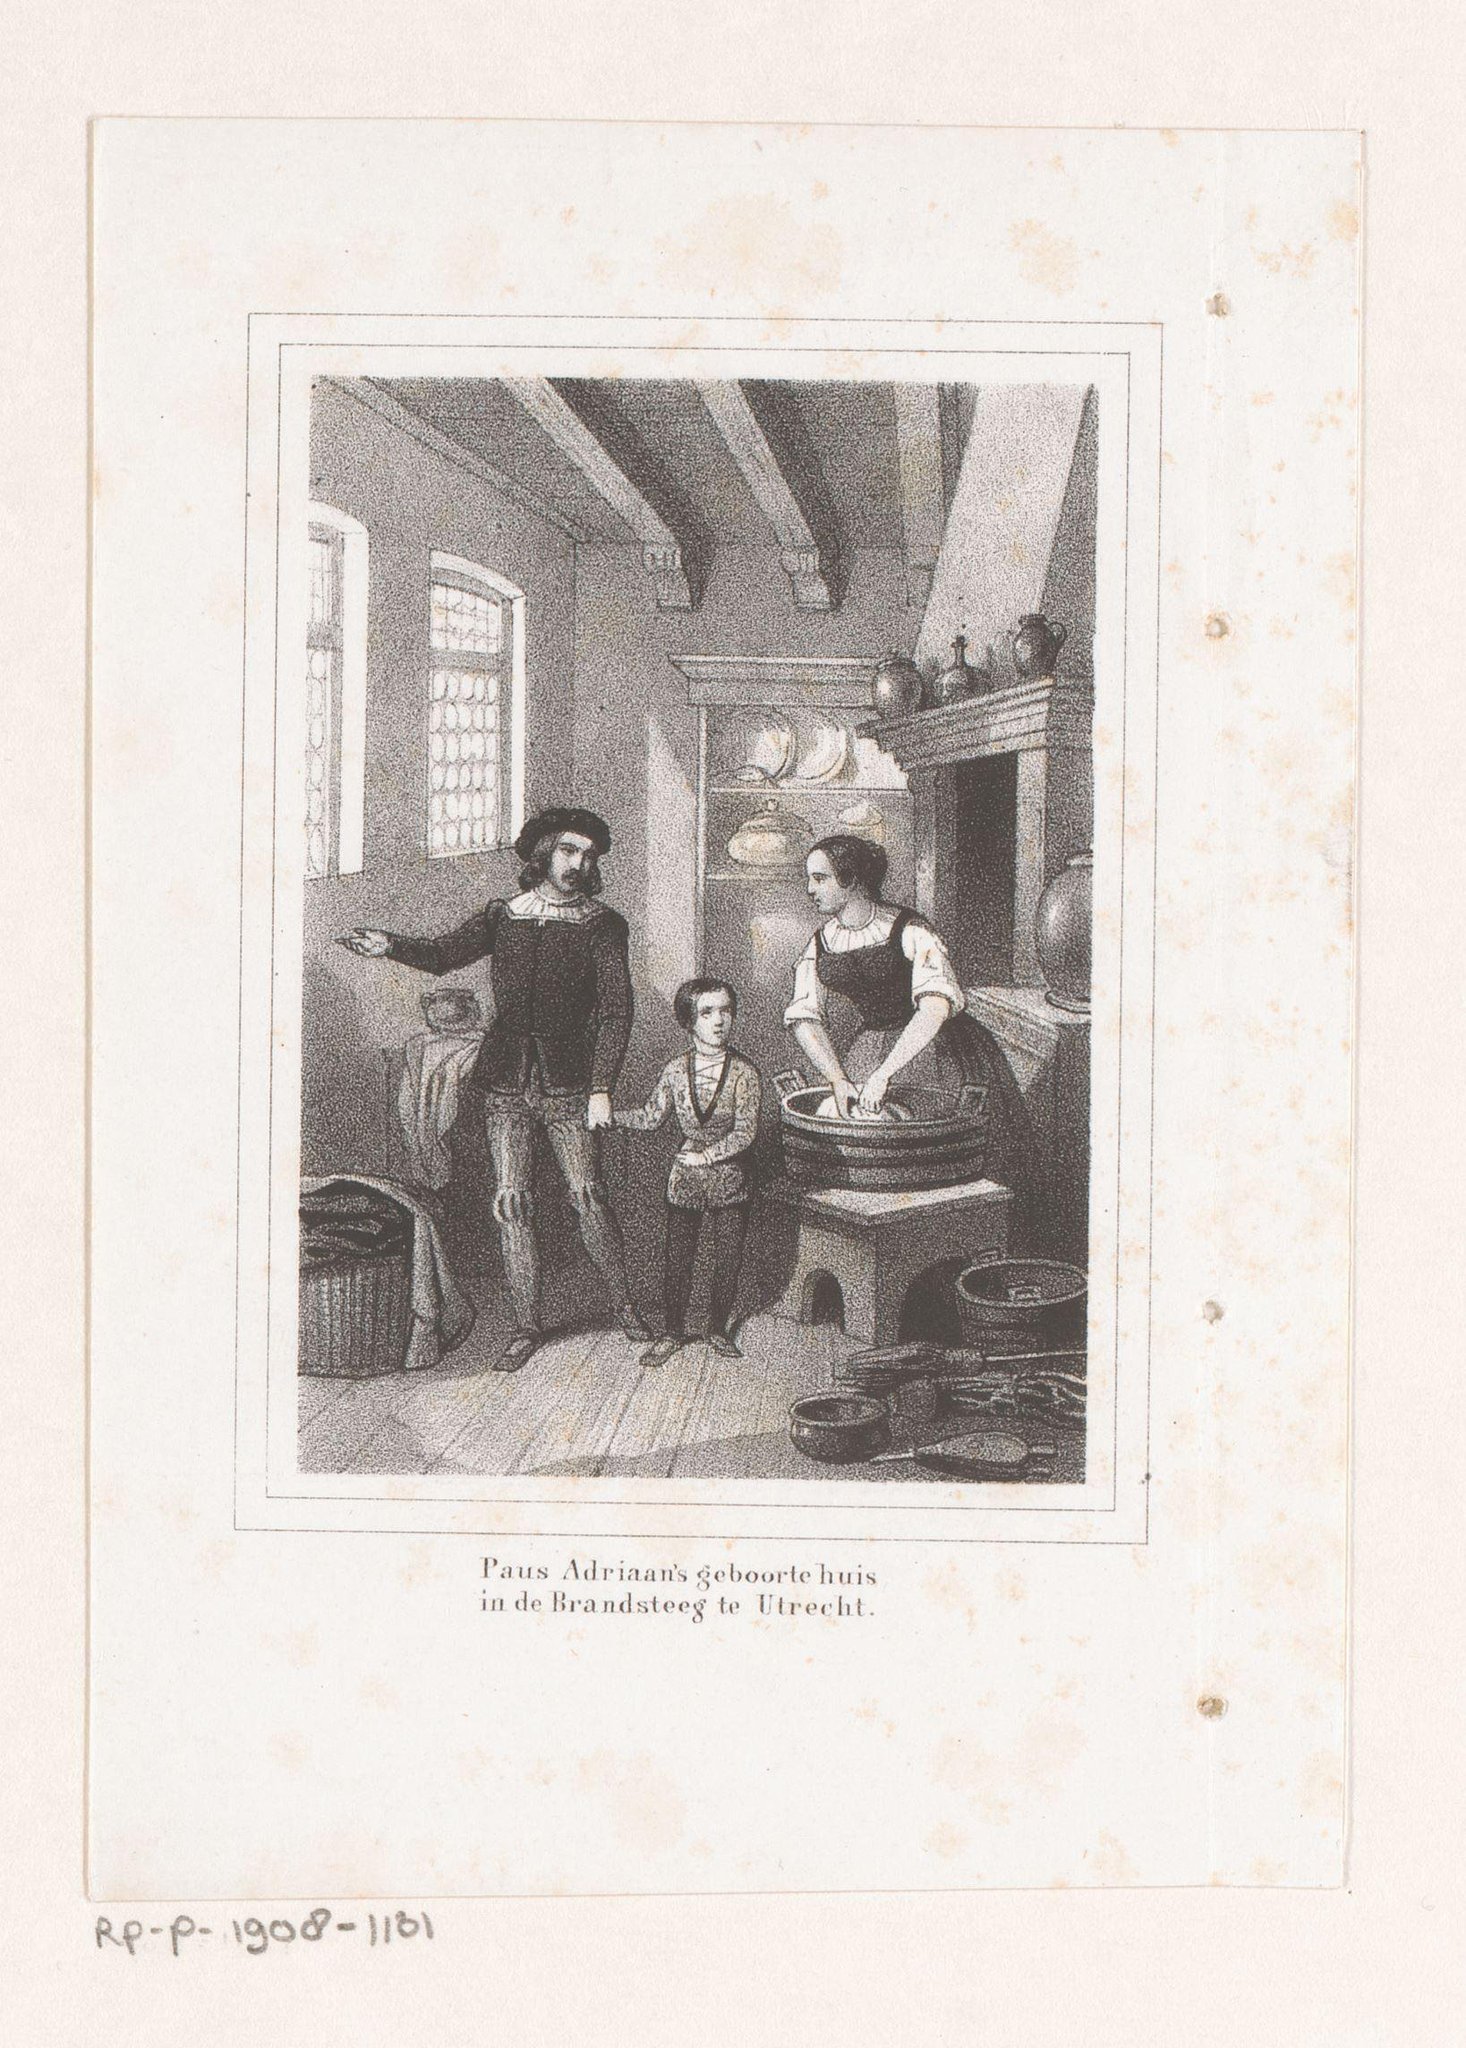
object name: print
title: Paus Adriaan's geboortehuis in de Brandsteeg te Utrecht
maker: Anonymous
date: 1846-1847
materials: paper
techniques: lithograph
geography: the hague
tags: rome, boy (child between toddler and youth), interior of the house, washing up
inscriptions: collector's mark: Lugt 2228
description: Deze prent is gedrukt op een niet versneden blad samen met RP-P-1908-1133 t/m RP-P-1908-1135.